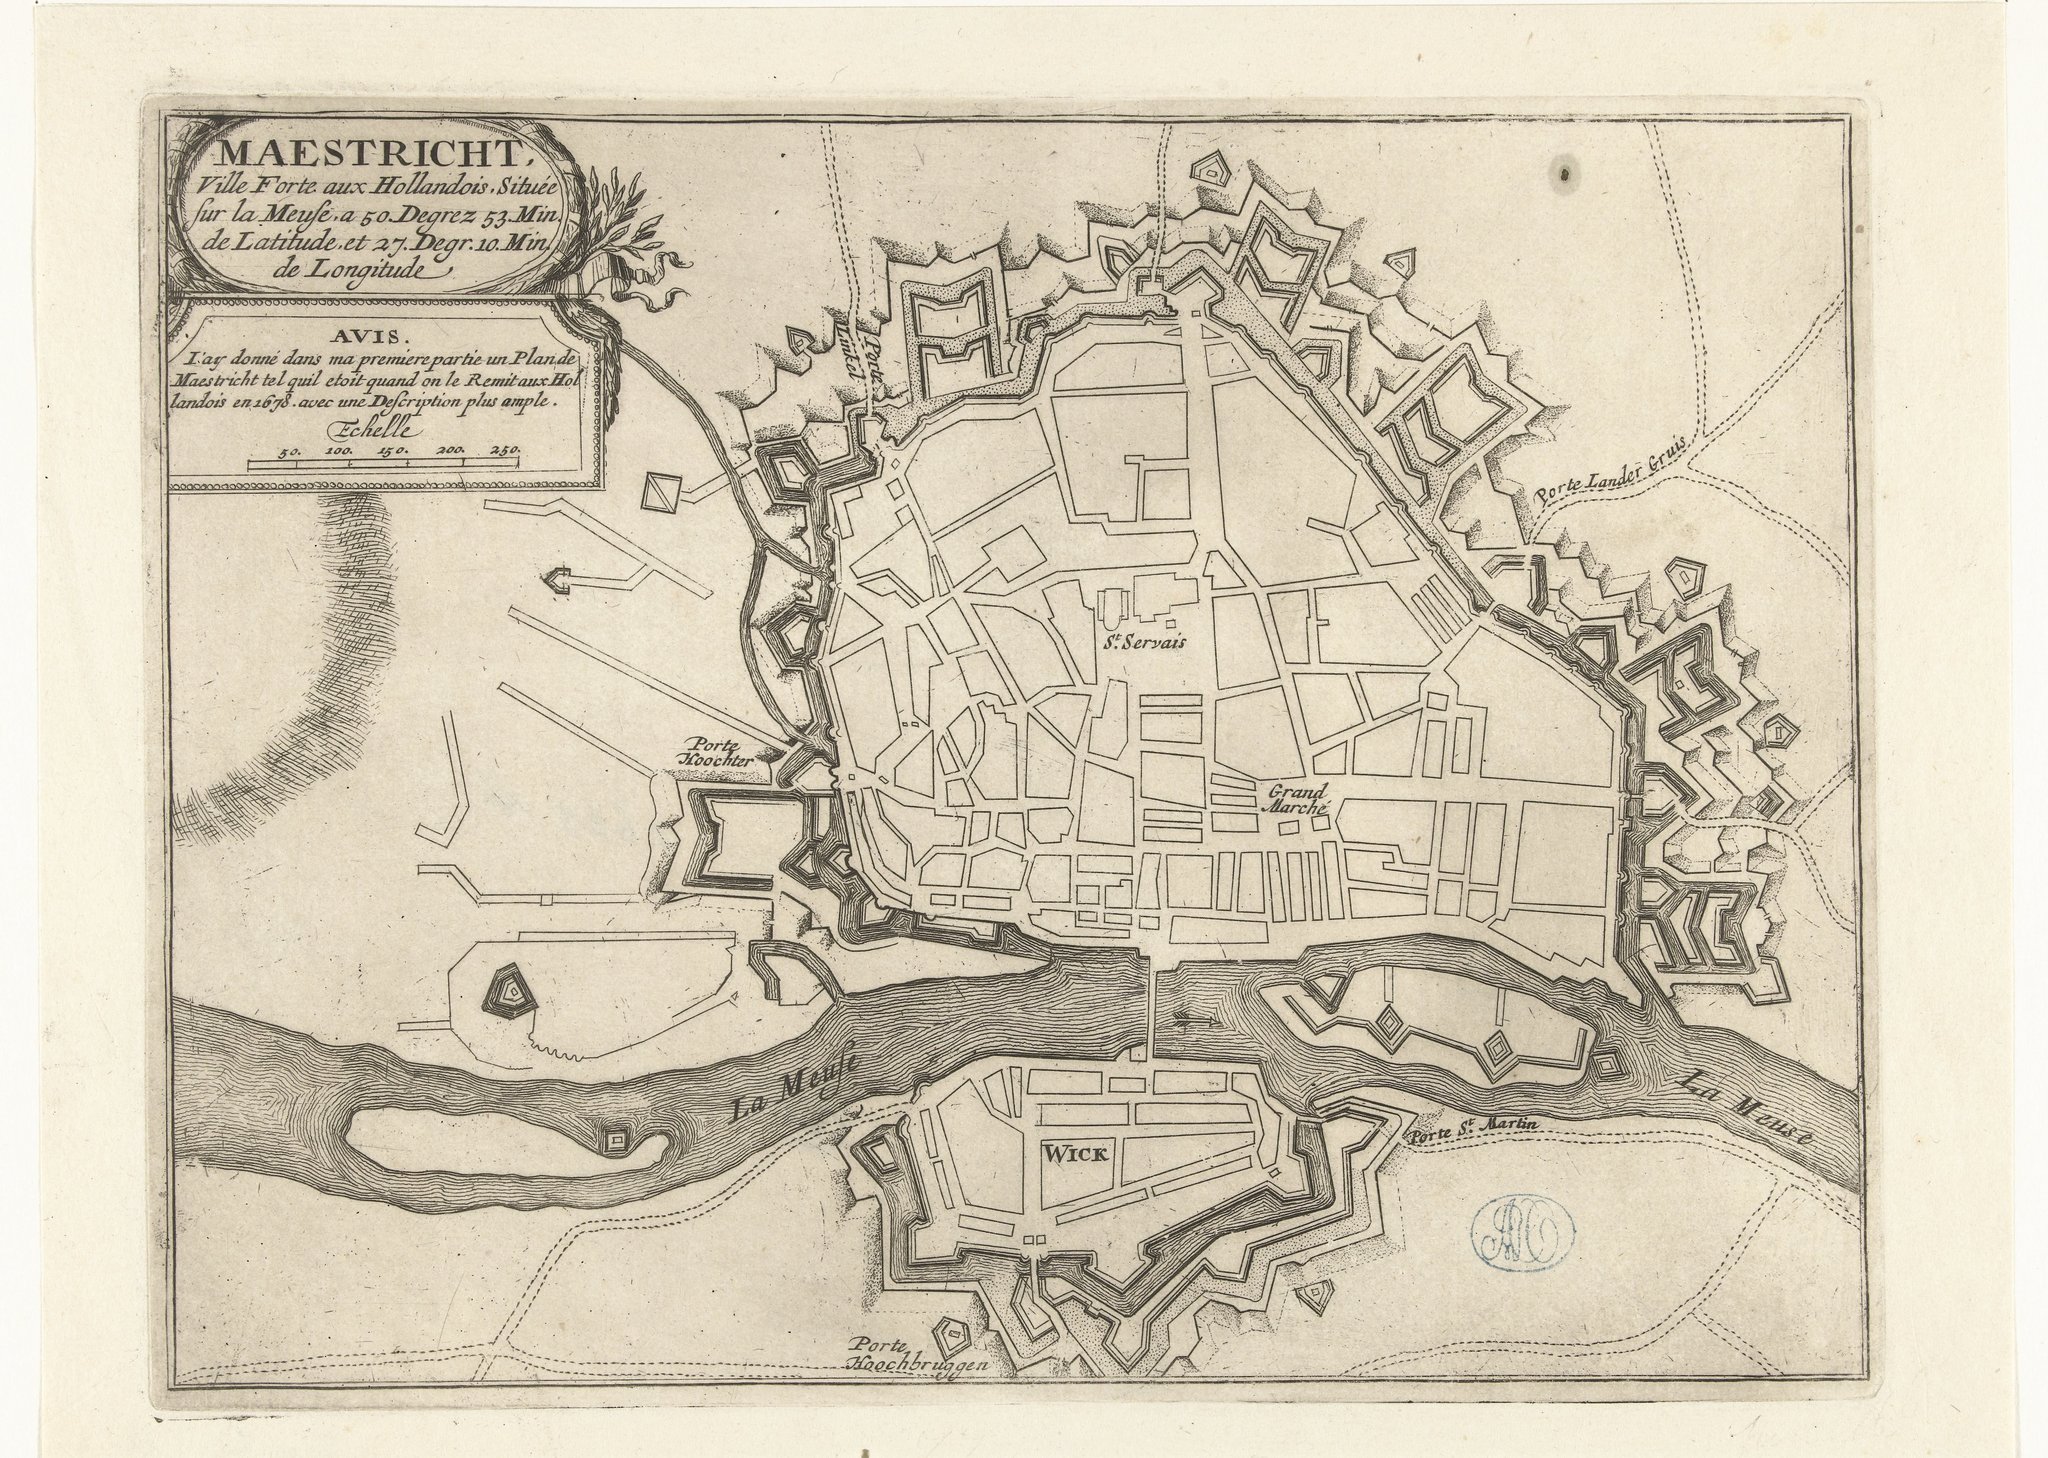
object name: print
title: Maestricht, Ville Forte aux Hollandois, Située sur la Meuse (...)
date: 1690-1697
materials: paper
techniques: etching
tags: maps of cities, maastricht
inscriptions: collector's mark: Lugt 195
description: Prent in huidige staat ook gebruikt in: Fer, Nicolas de. Les forces de l'Europe, ou description des principales villes, avec leurs fortifications : dessignées par les meilleurs ingenieurs, particulierement celles (…). Parijs: Nicolas de Fer, 1690-1695. Fer, Nicolas de. Le theatre de la guerre, dans les Pays-Bas, ou representation des principales villes qui sont en Flander, Hainaut, Brabant (...). Parijs: Nicolas de Fer, 1697. Niet in Frederik Muller; door het RPK toegevoegd nummer.